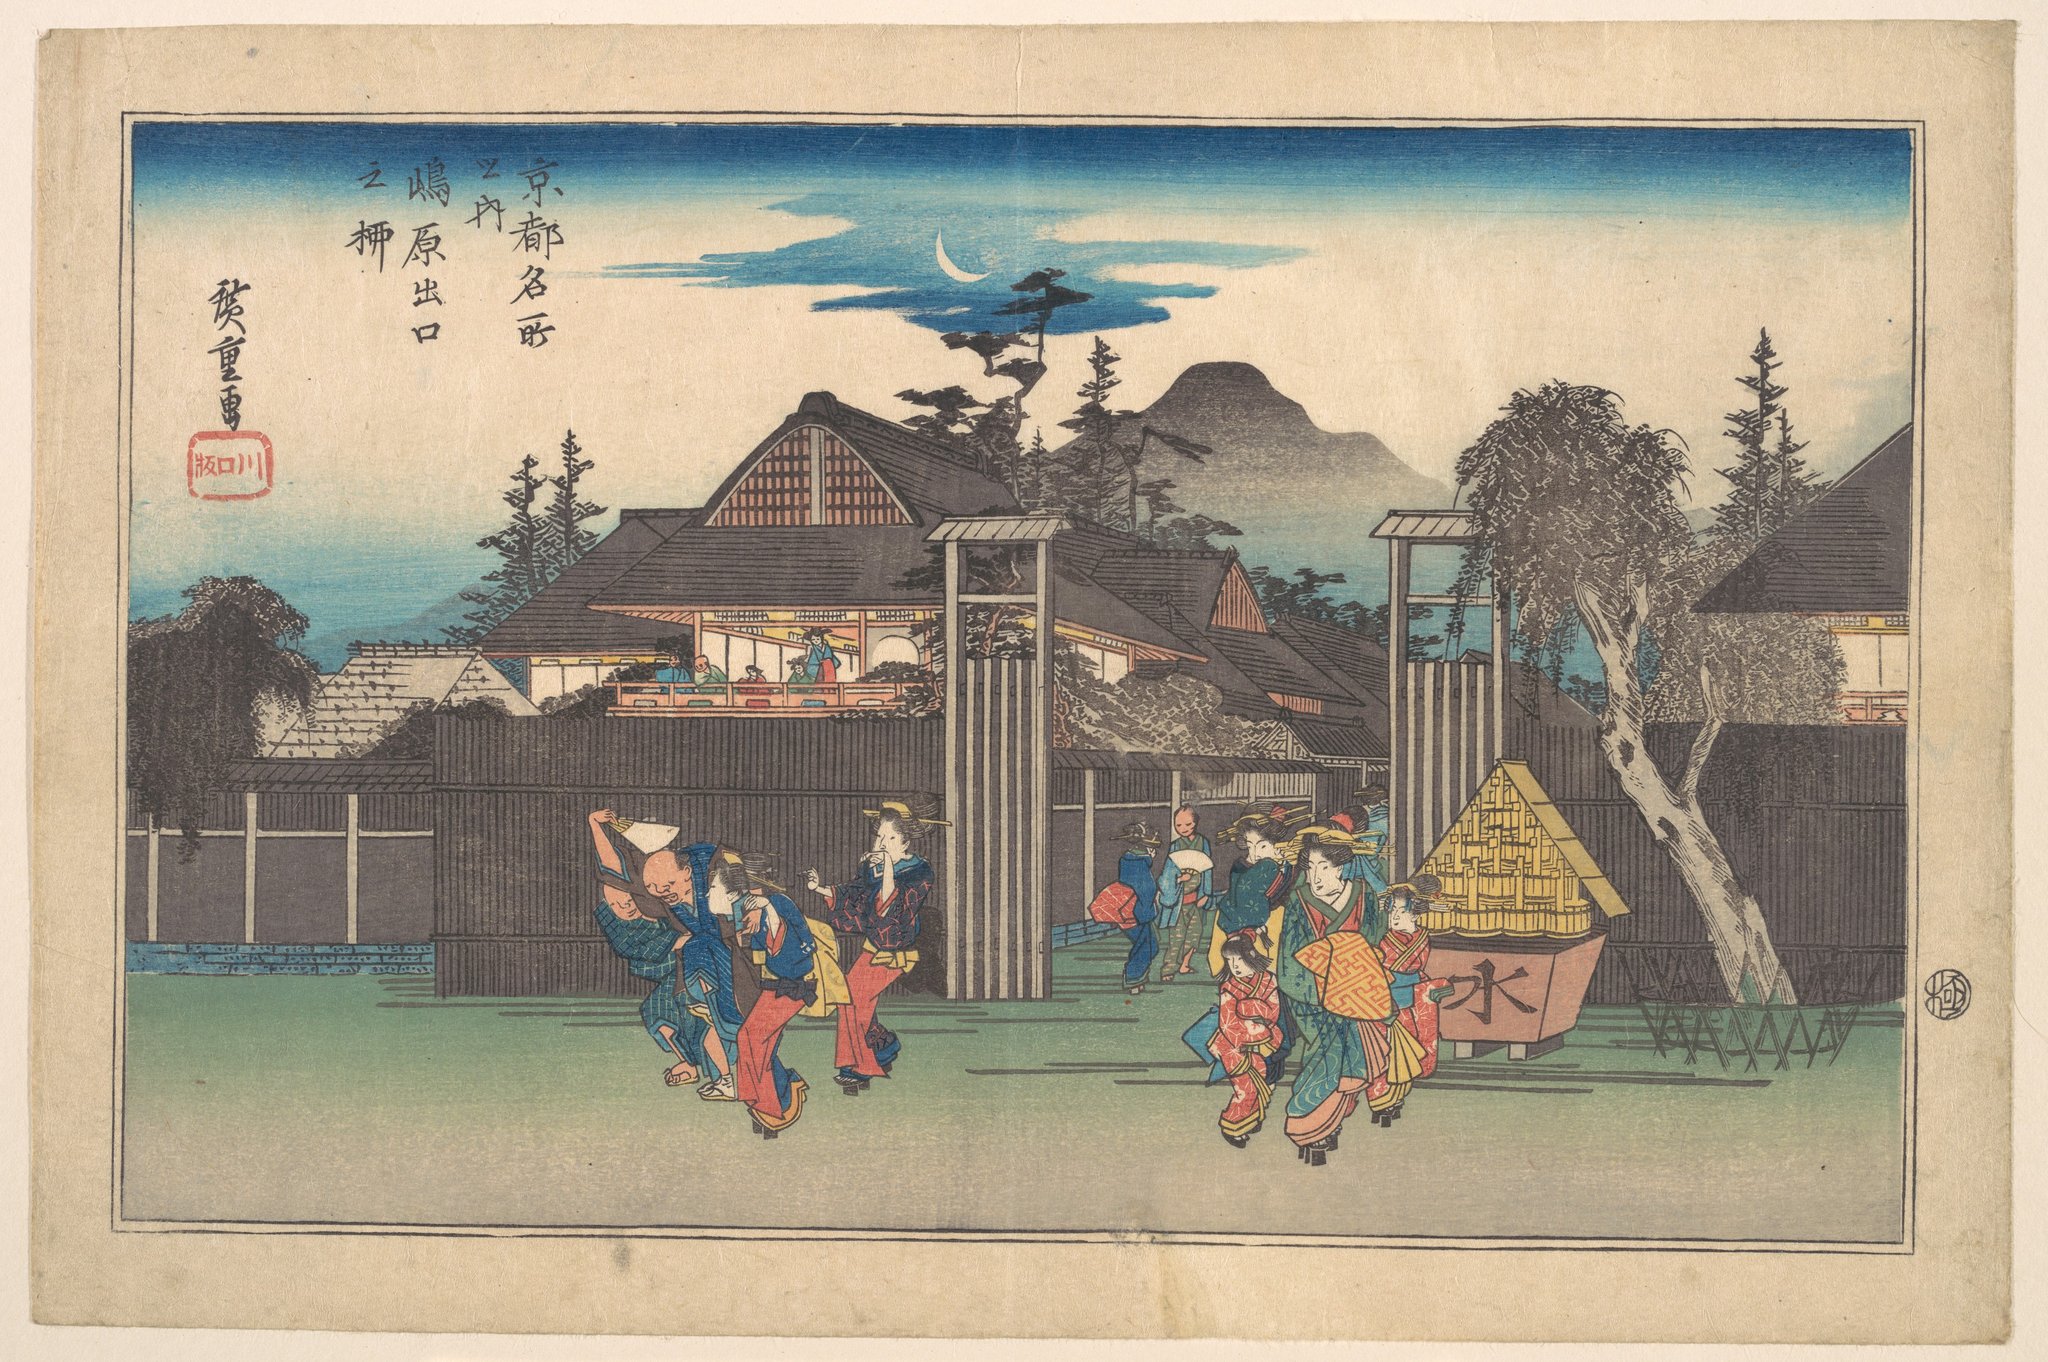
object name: woodblock print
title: Gate of the Shimbara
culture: japanese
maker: utagawa hiroshige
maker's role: artist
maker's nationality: japanese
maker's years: 1797-1858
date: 1797-1858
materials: ink, paper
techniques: woodblock print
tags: gates,houses,men,women,moon